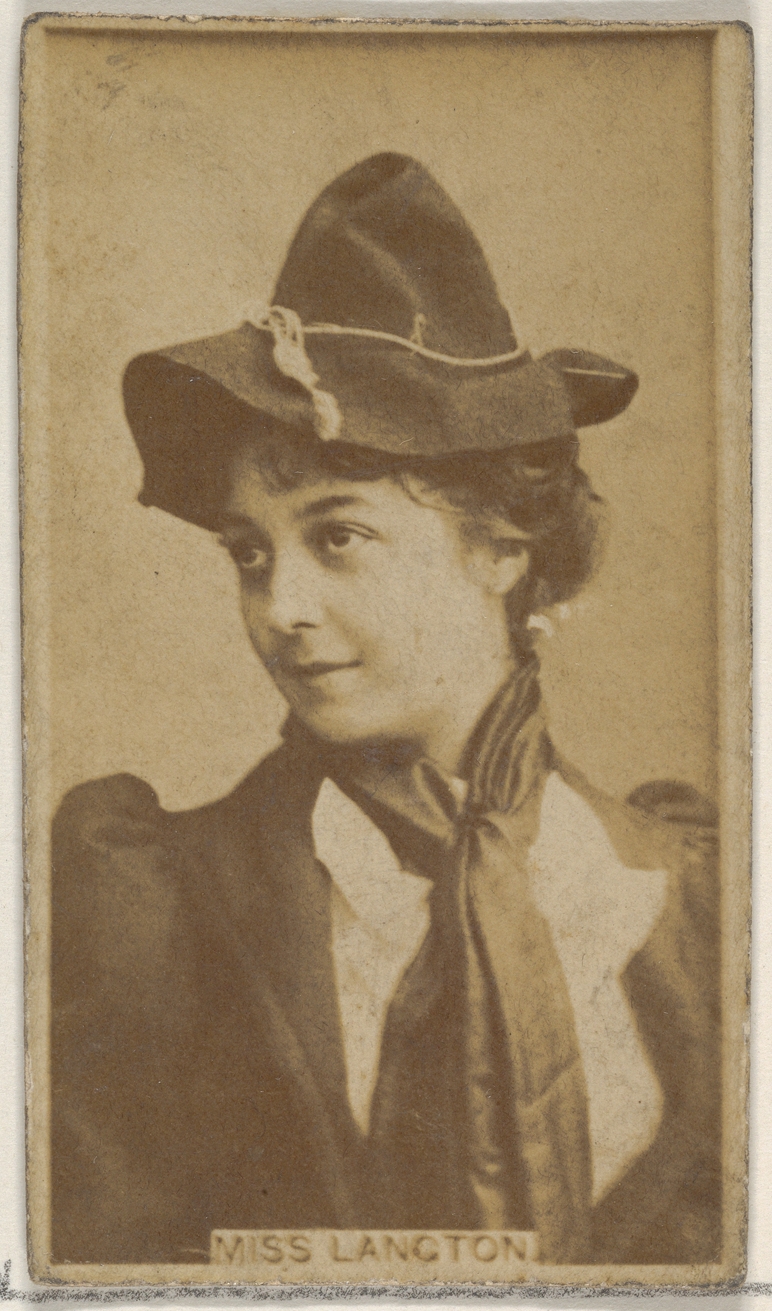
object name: photograph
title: Miss Langton, from the Actors and Actresses series (N45, Type 8) for Virginia Brights Cigarettes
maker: allen & ginter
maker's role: publisher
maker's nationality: american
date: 1888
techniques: albumen silver print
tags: portraits,women,actresses